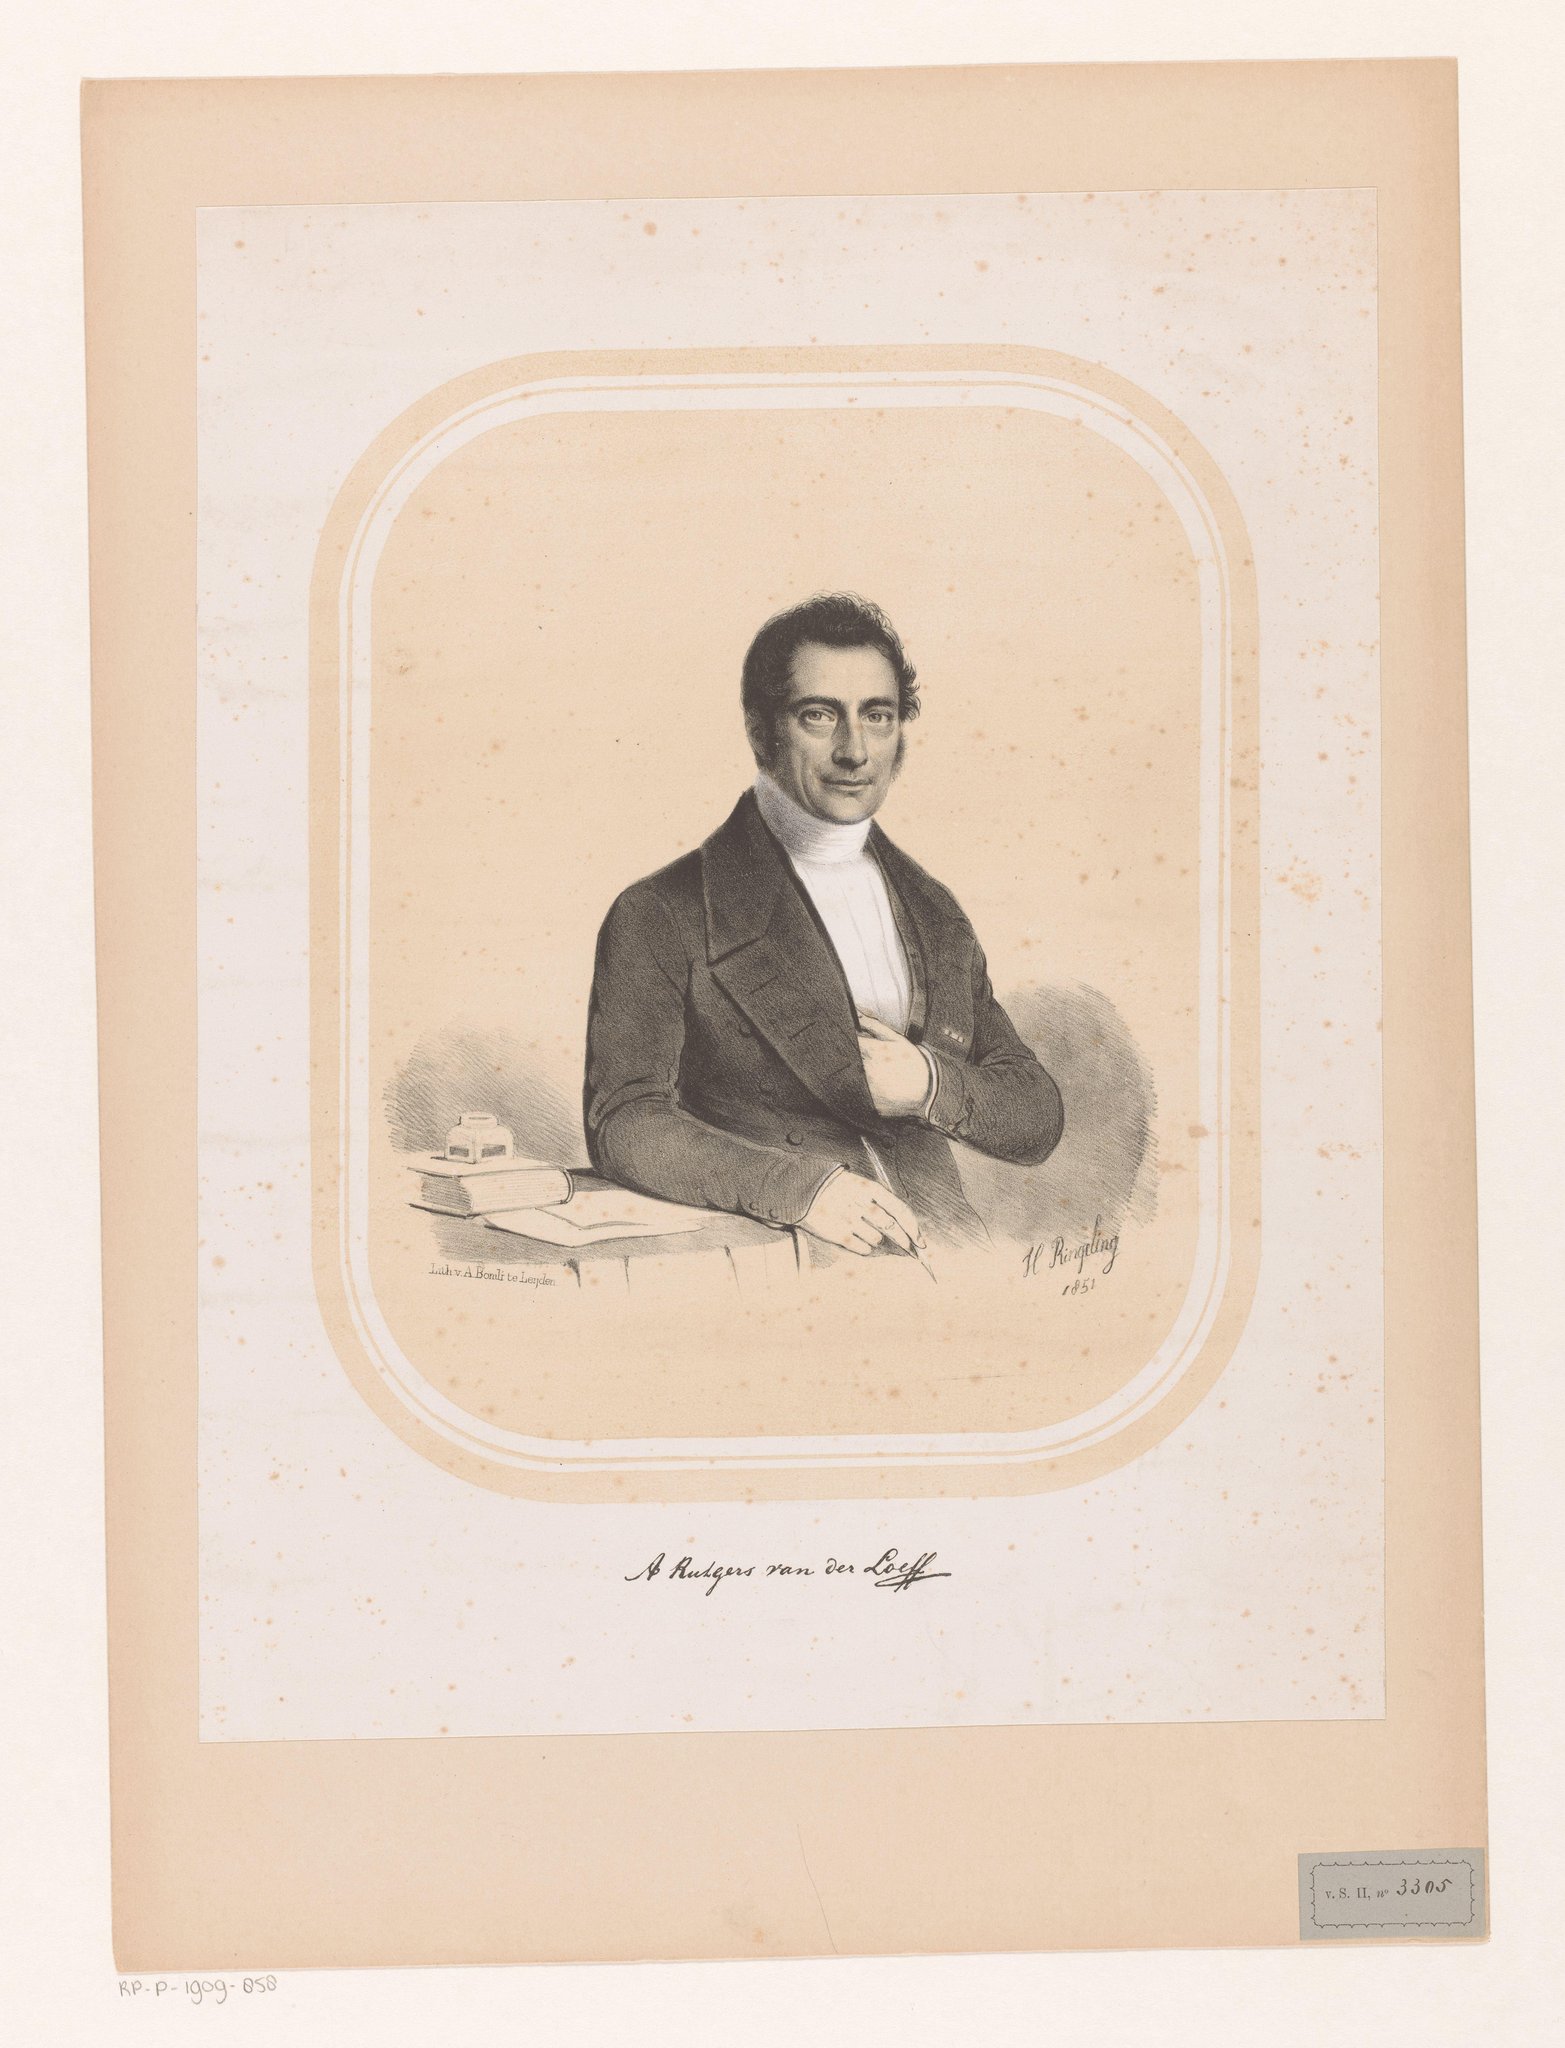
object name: print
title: Portret van Abraham Rutgers van der Loeff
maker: abraham bomli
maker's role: boekhandelaar, steendrukker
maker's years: 1807-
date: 1851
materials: paper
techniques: tone lithography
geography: leiden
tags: historical persons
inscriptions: collector's mark: Lugt 2228